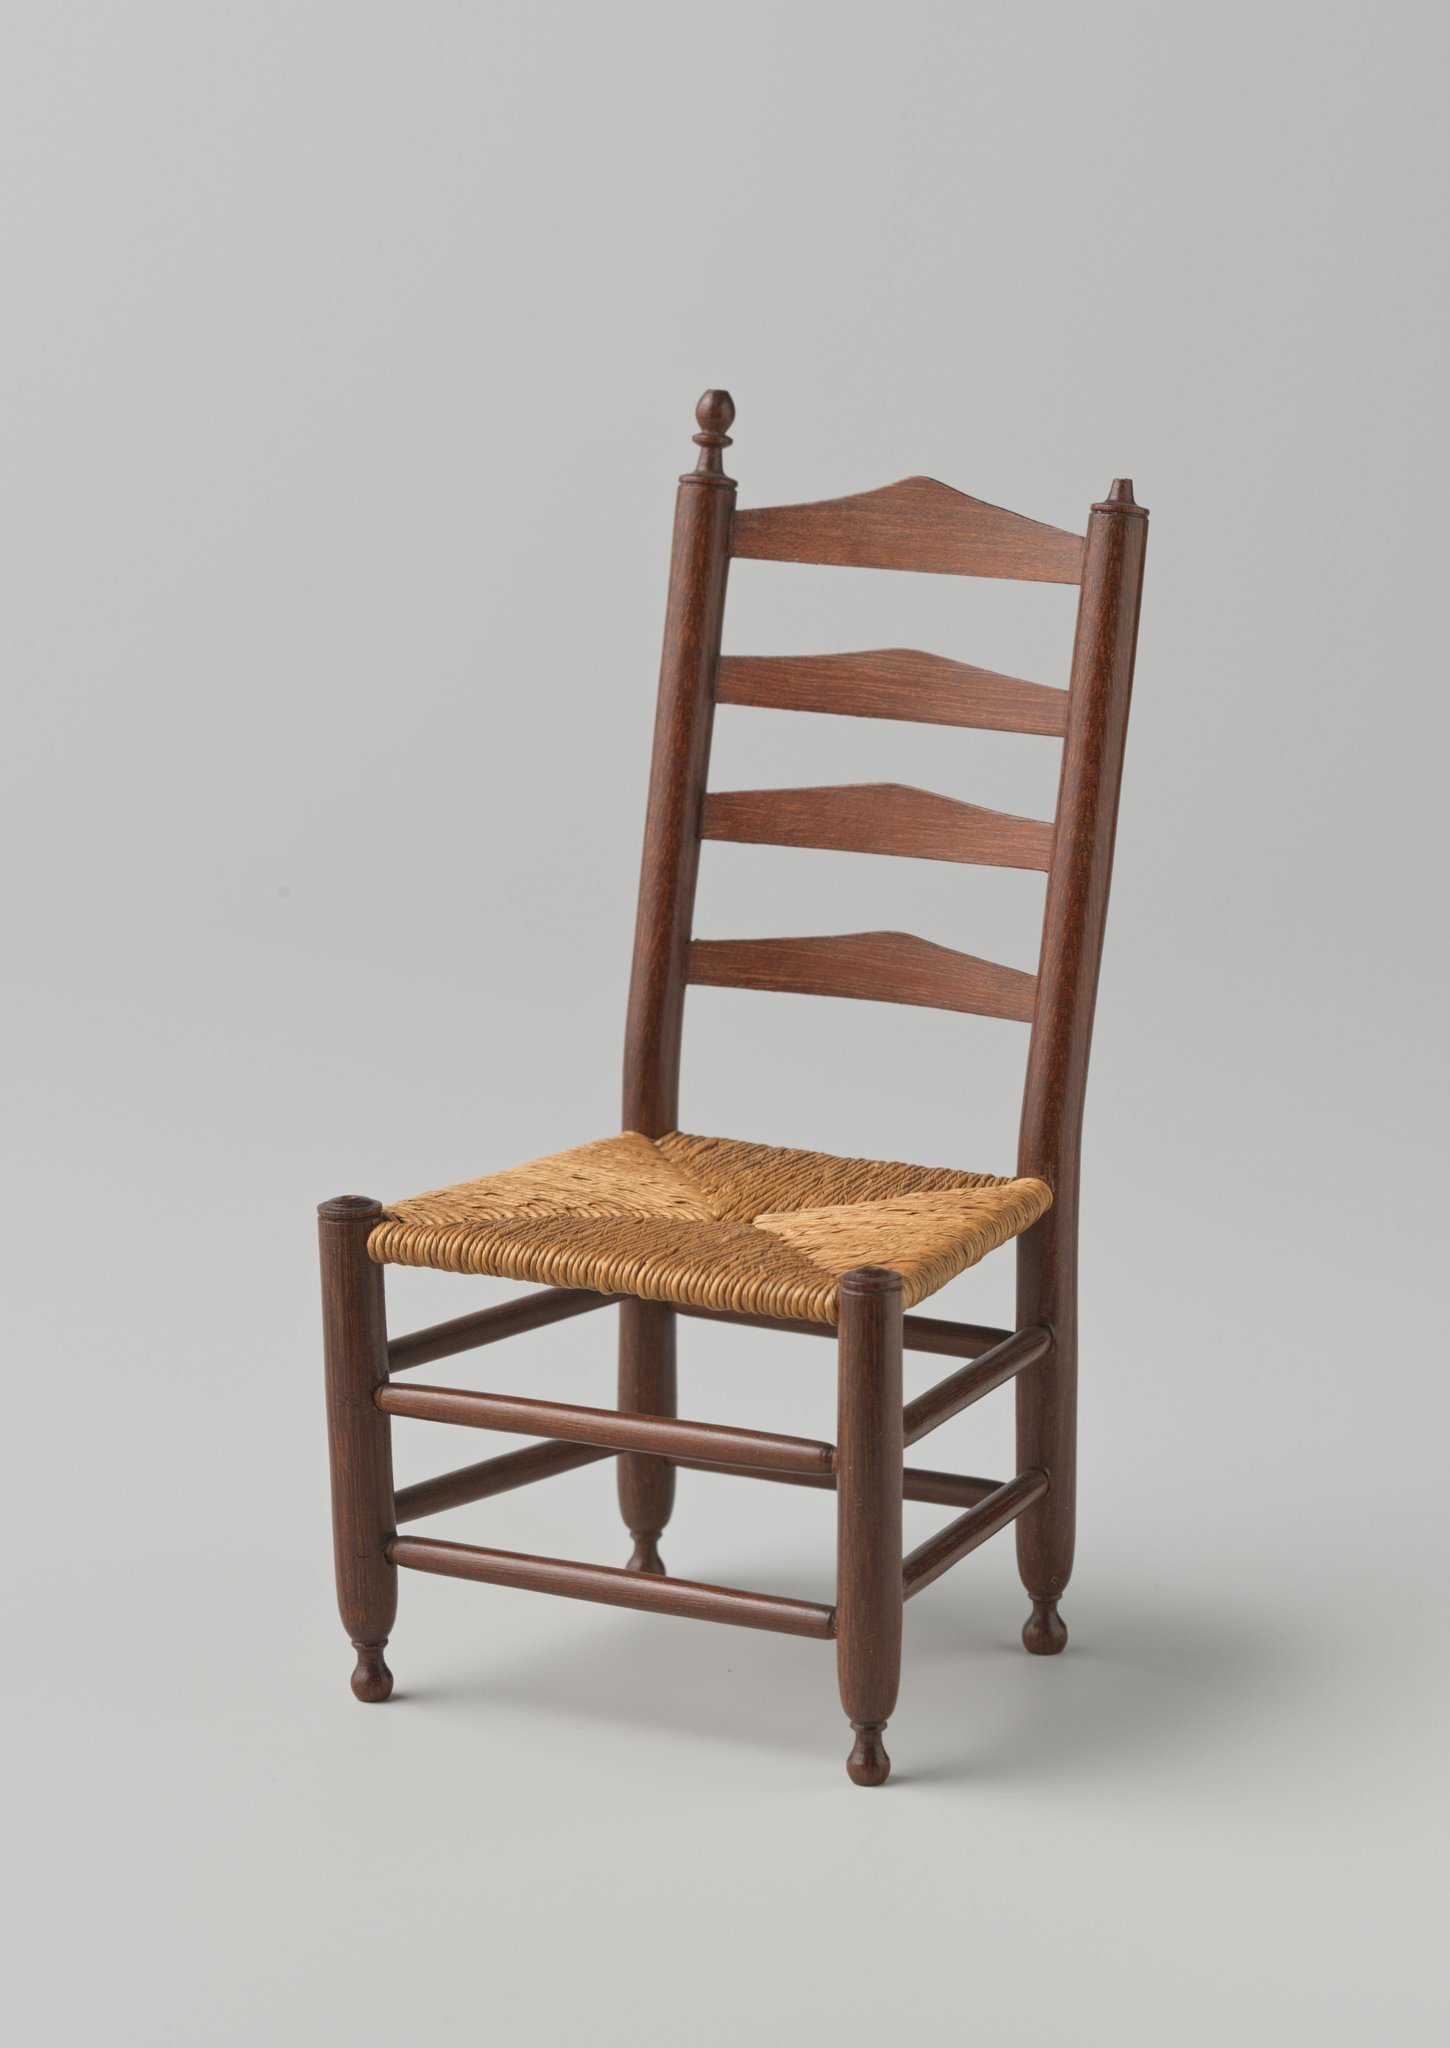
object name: miniature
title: Knopstoel van hardhout met gladde, gedraaide stijlen en dwaarsregels; voorpoten en achterstijlen eindigend in fijn gedraaide knoppen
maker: Anonymous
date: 1690-1710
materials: wood, fiber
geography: amsterdam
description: Van deze stoel ontbreekt een knop. De stoel maakt deel uit van een viertal. Bij elke stoel hoort een kussen.